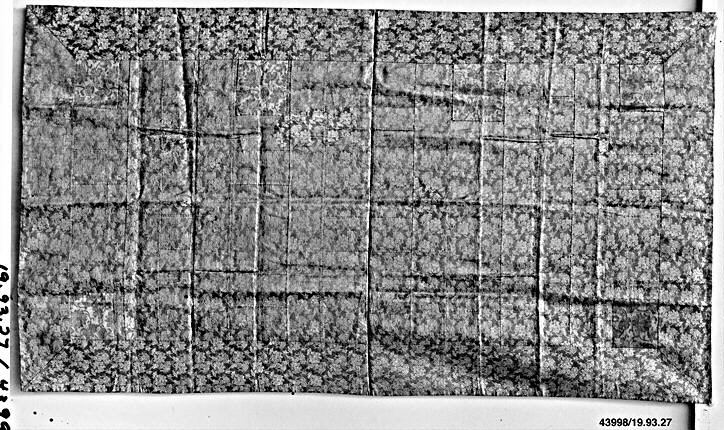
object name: robe, priest's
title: Priest's Robe (Shichijō)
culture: japanese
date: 1573-1592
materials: metal thread, silk